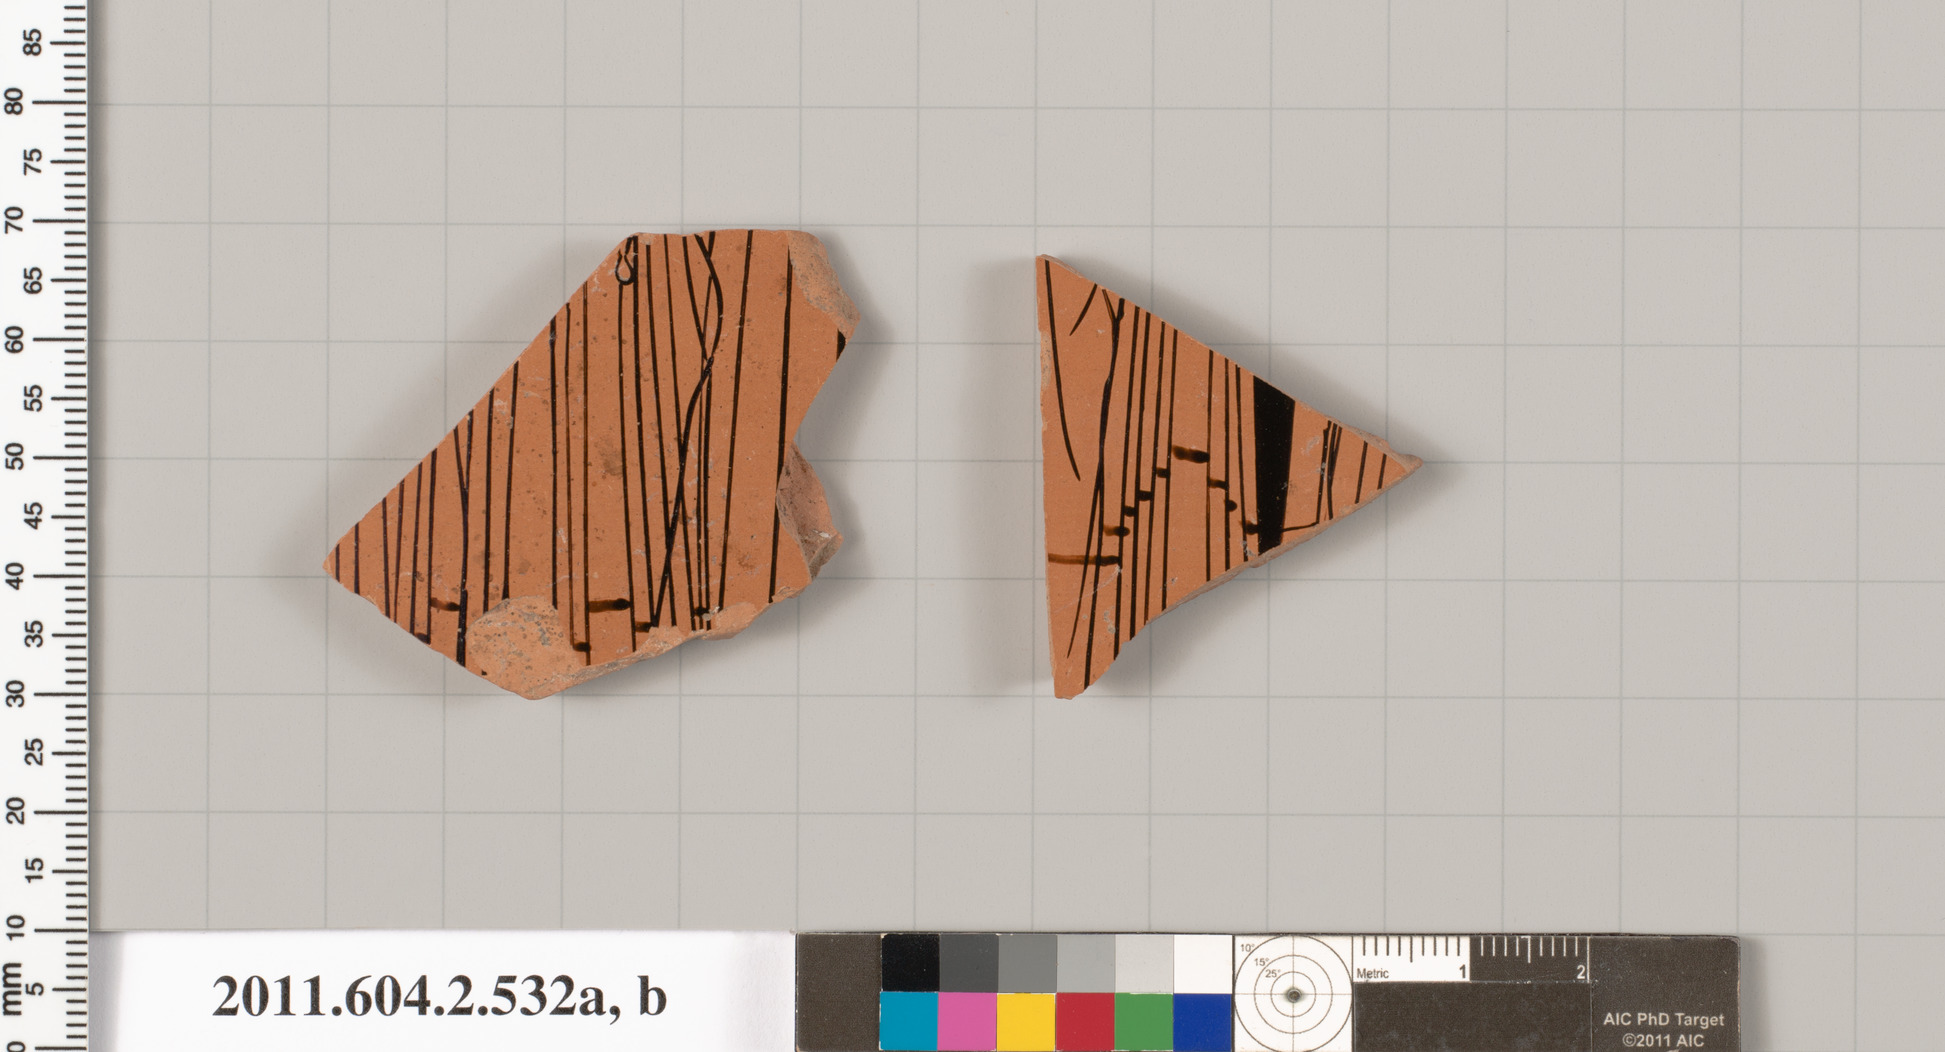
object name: column krater fragment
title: Terracotta fragments of a column-krater (bowl for mixing wine and water)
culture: greek, attic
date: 475-451 BCE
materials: terracotta